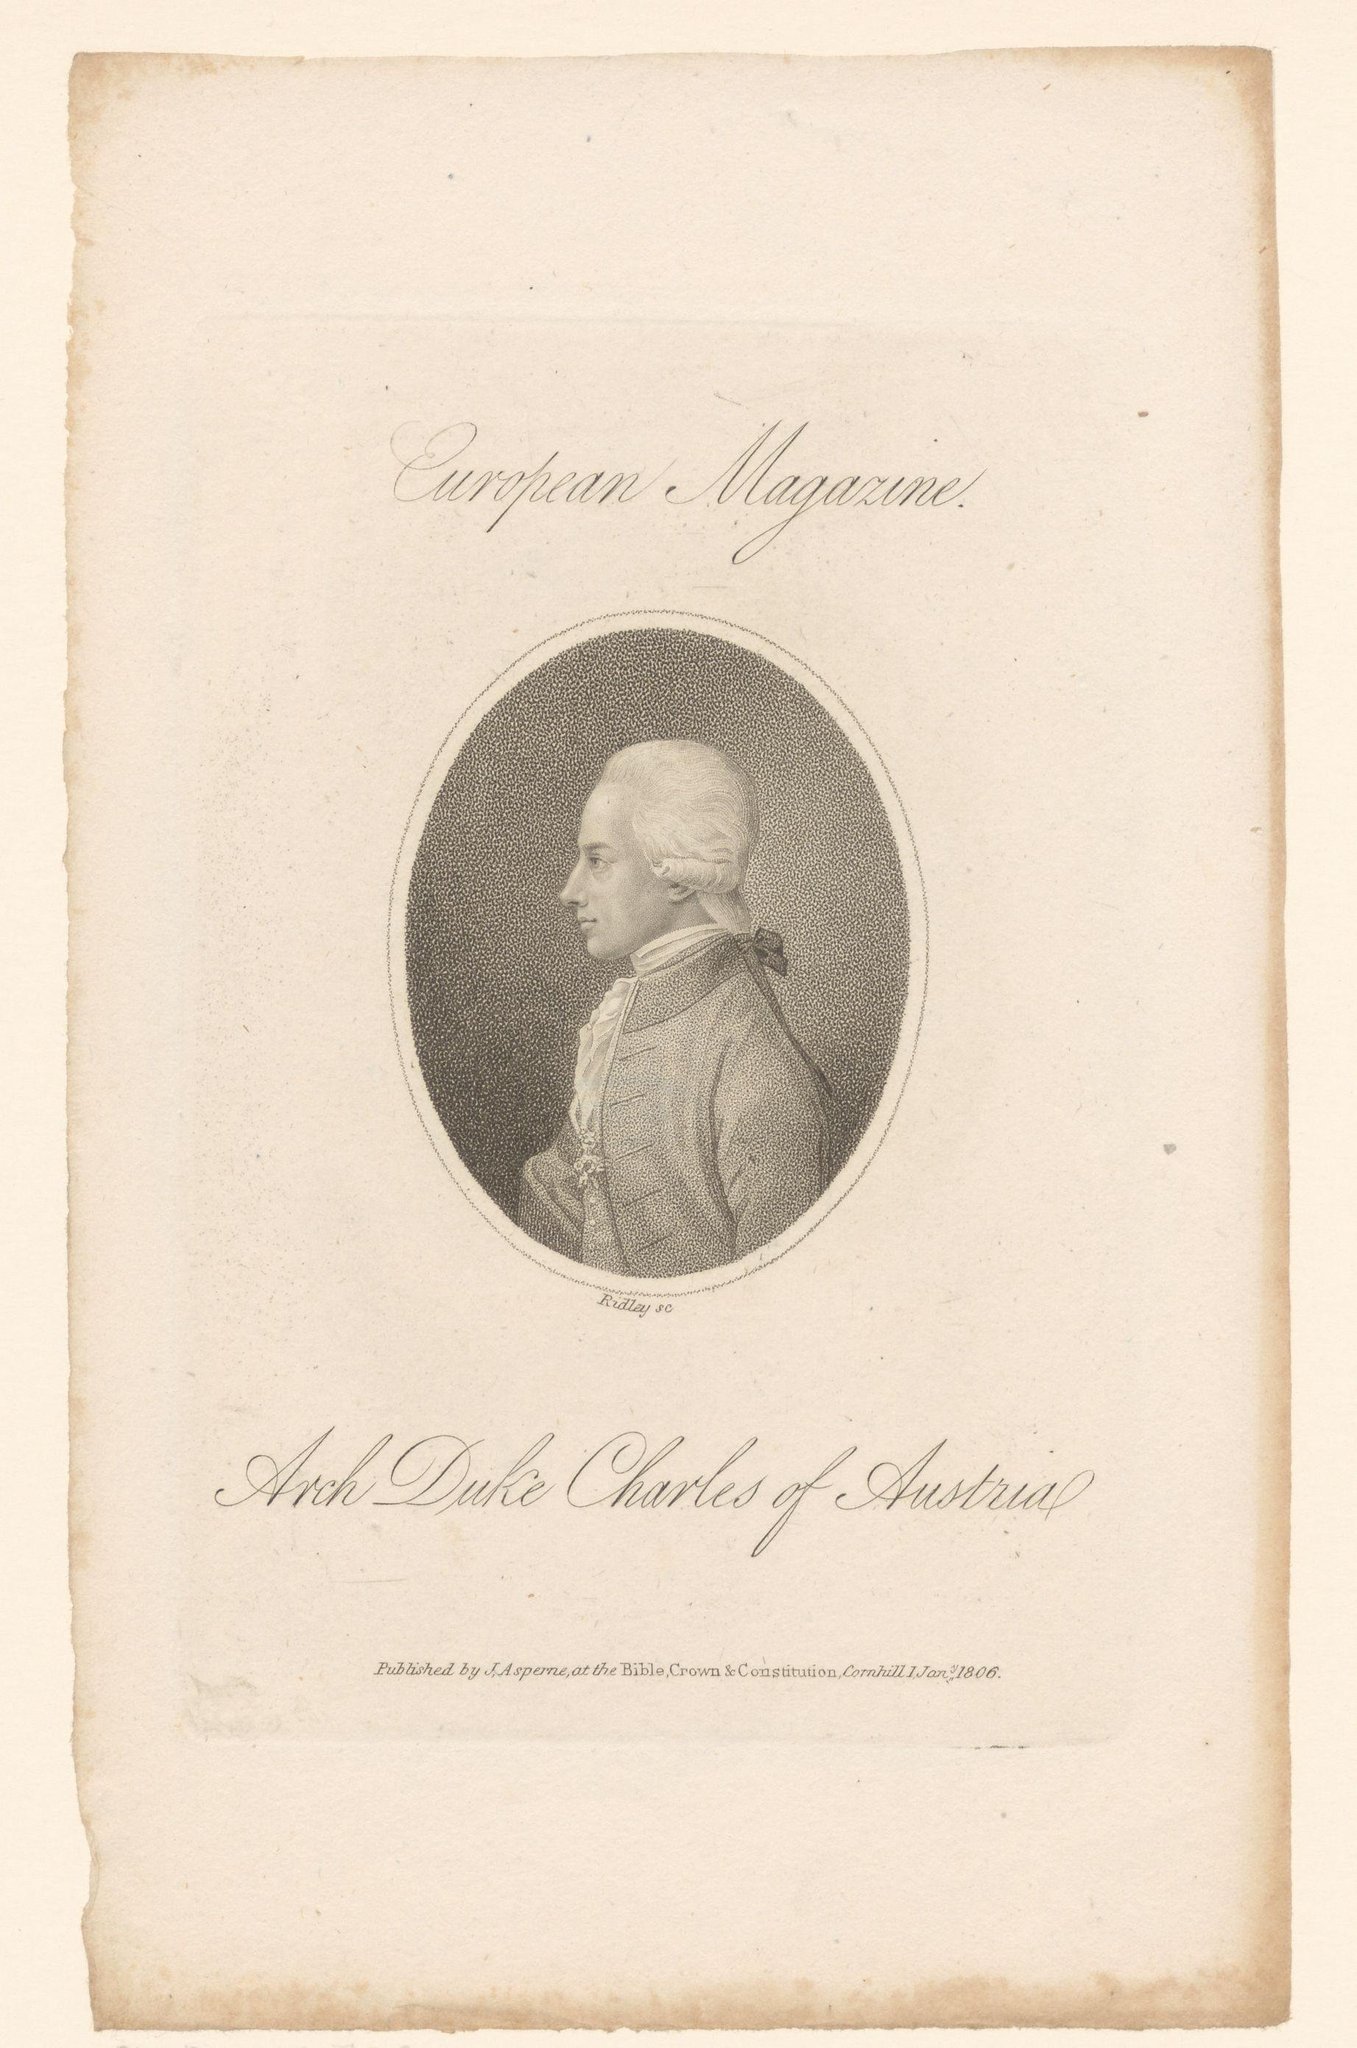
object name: print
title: Portret van Karel van Oostenrijk-Teschen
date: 1806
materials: paper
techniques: stippling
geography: london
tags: vienna, historical persons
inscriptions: collector's mark: Lugt 2228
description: Prent gebruikt in: European Magazine, 1806.